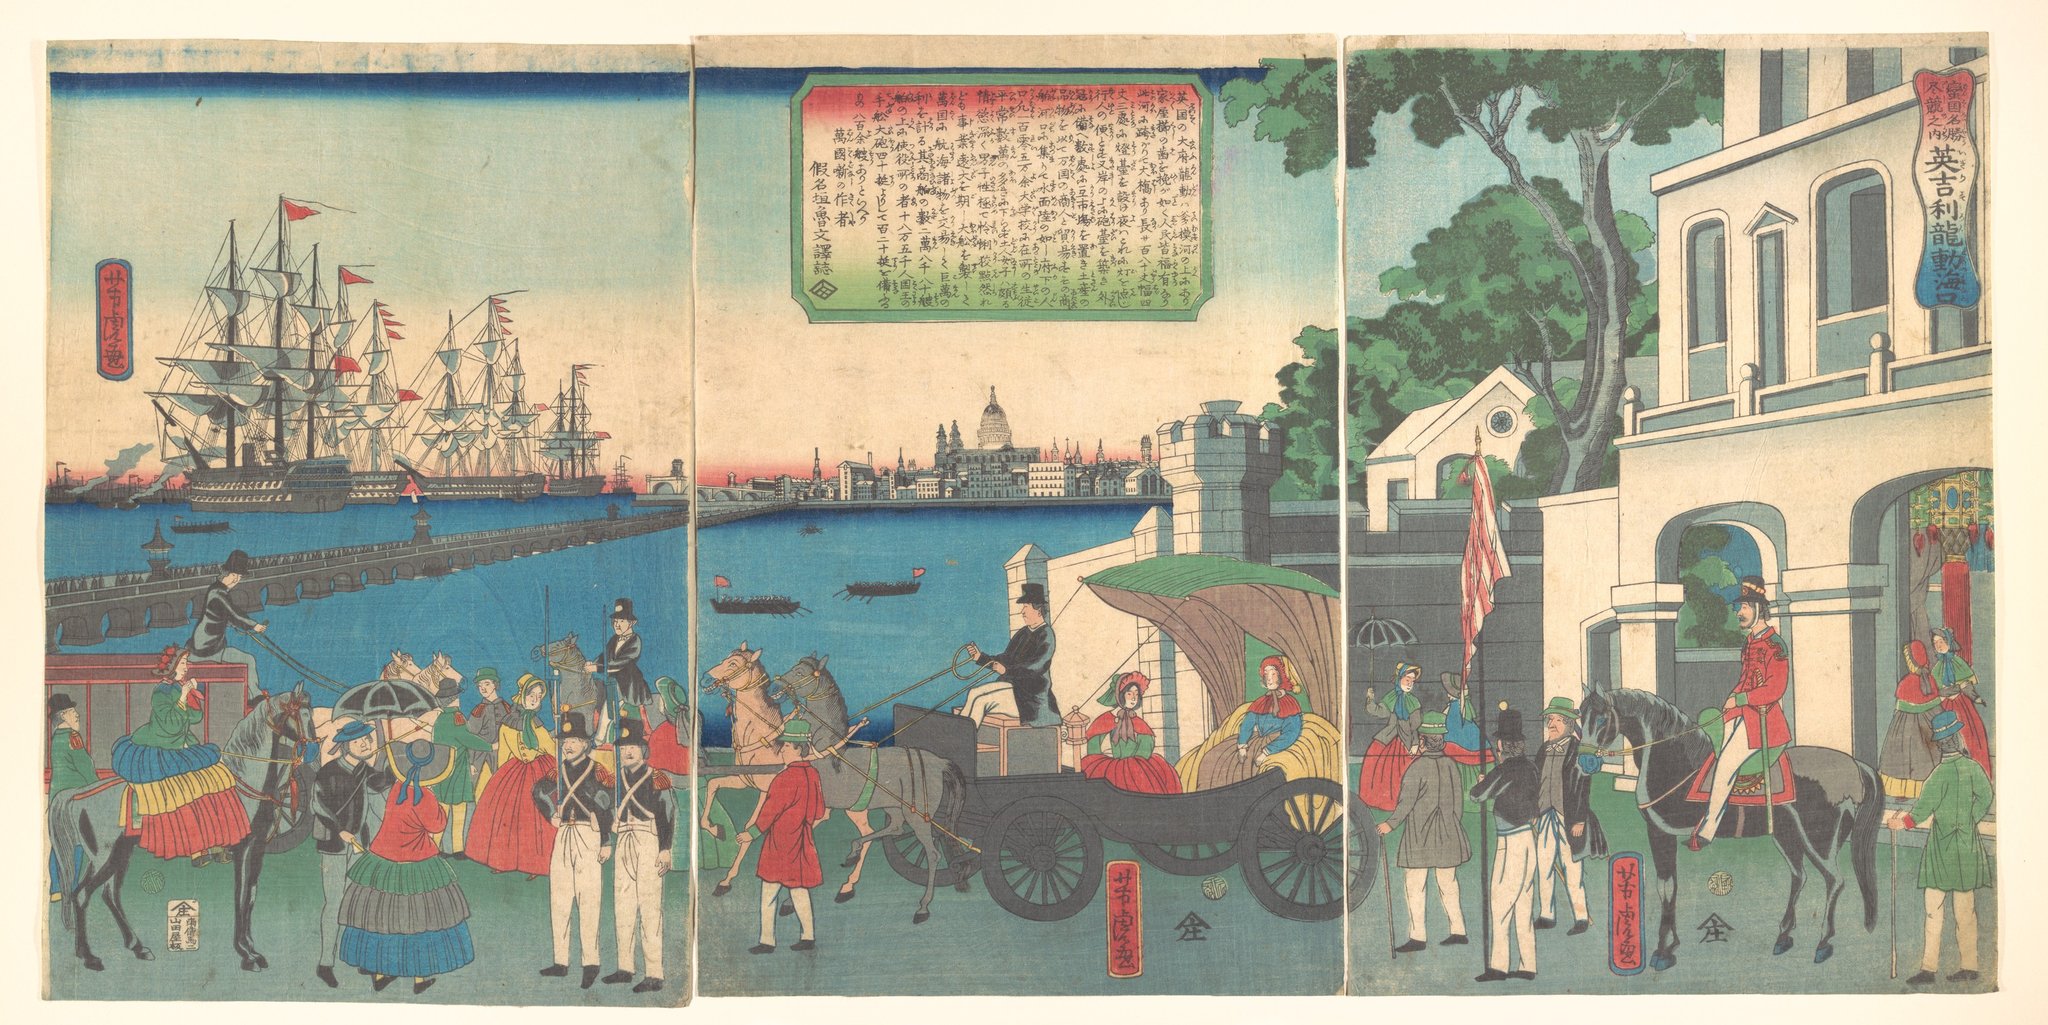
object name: print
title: The Port of London England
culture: japanese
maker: utagawa yoshitora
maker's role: artist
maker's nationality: japanese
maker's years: 1845-1880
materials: ink, paper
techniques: woodblock print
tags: horses,carriages,ships,london